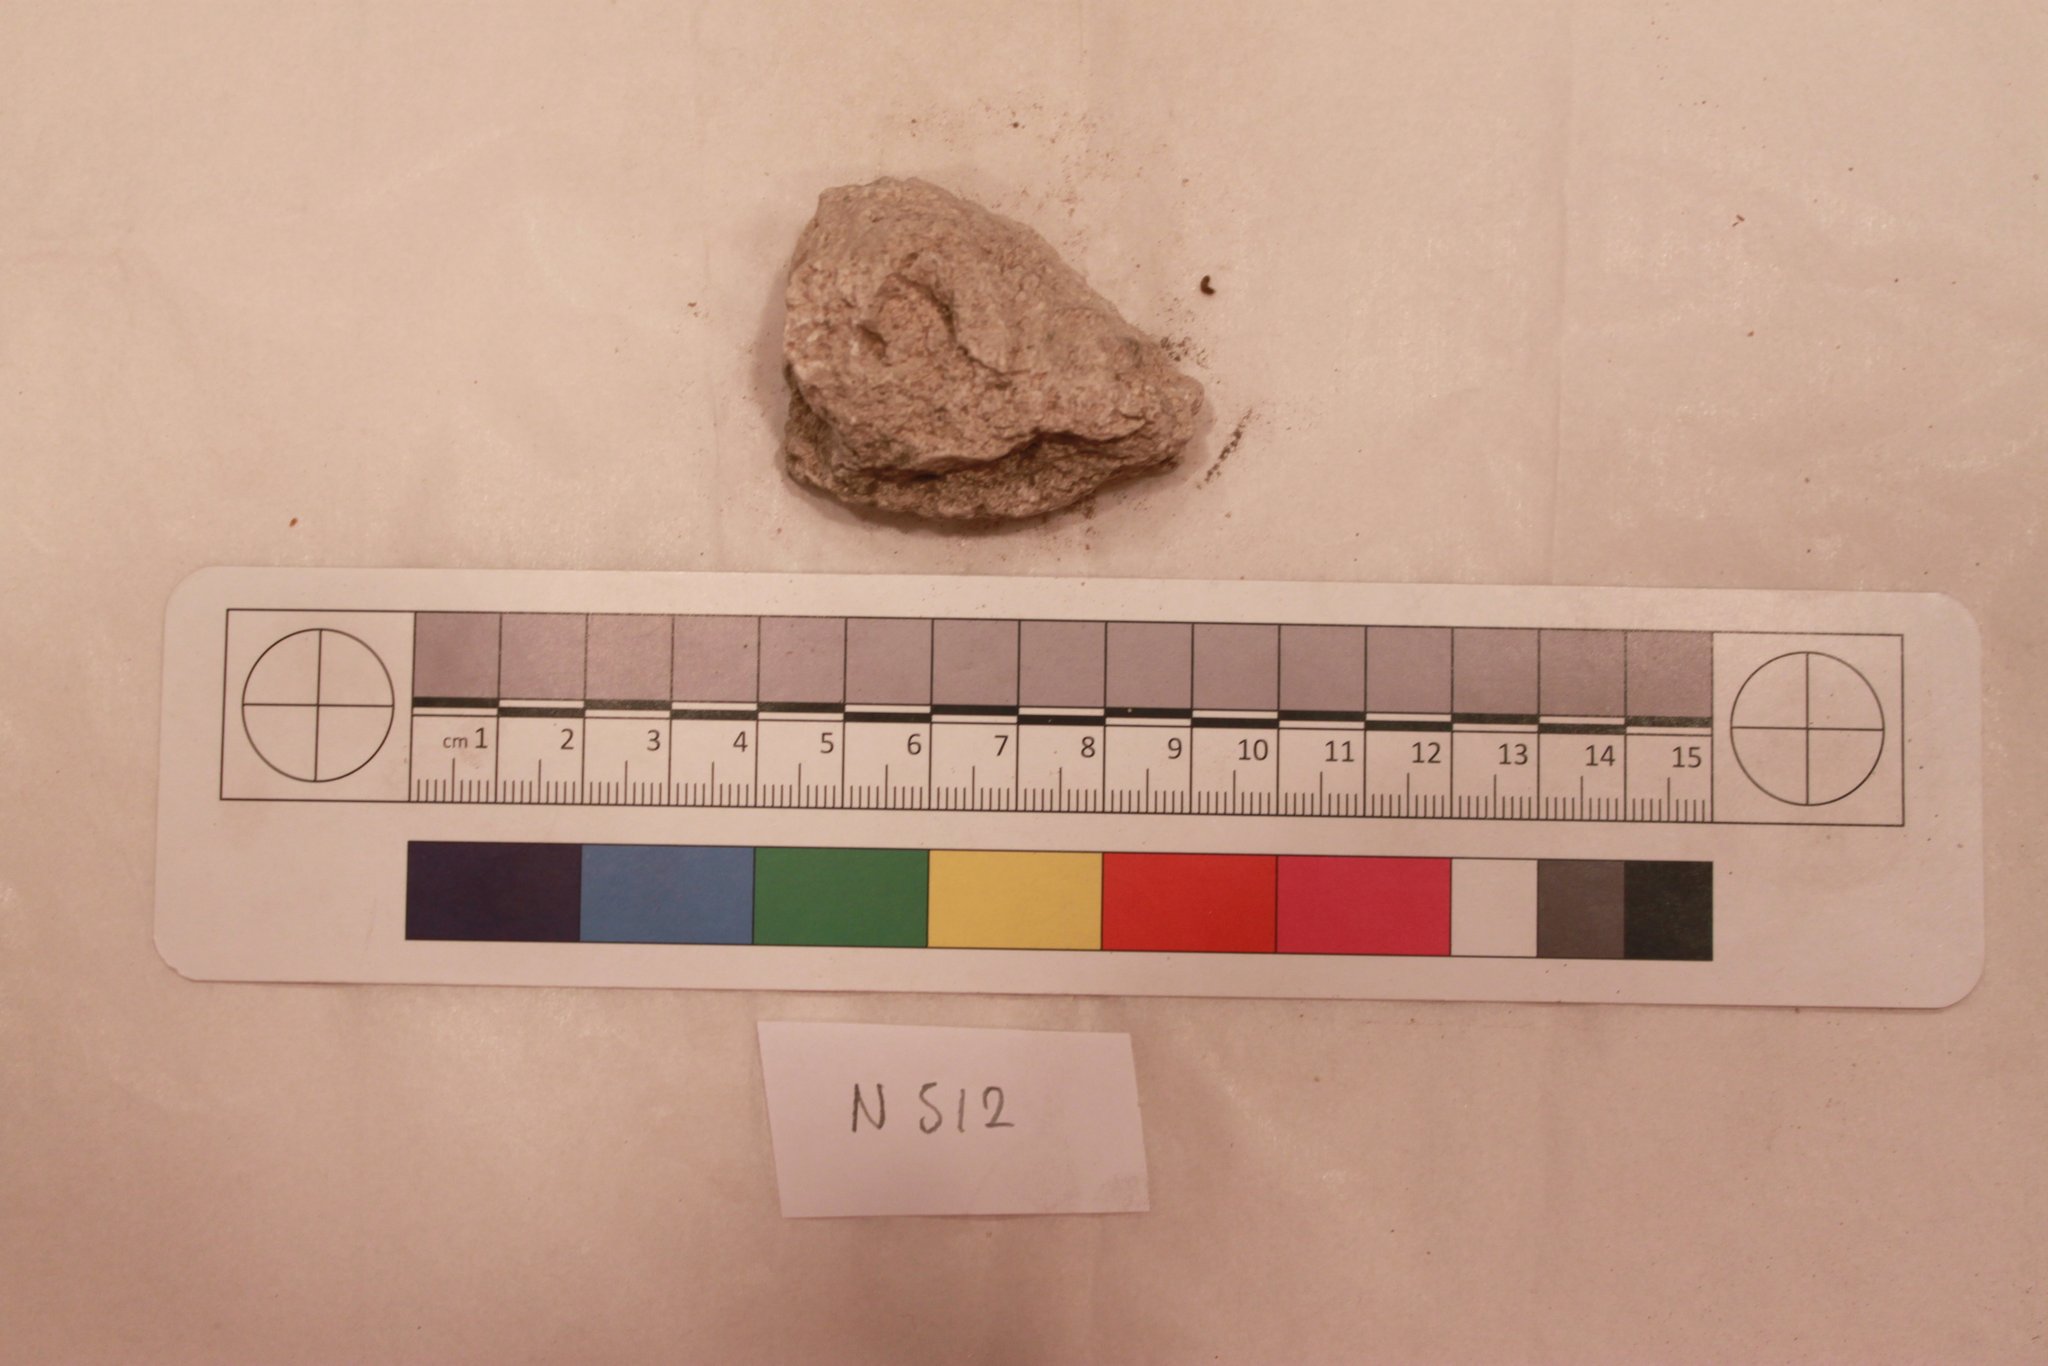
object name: fragment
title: Stucco Fragment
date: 701-1200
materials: plaster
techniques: carving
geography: iran